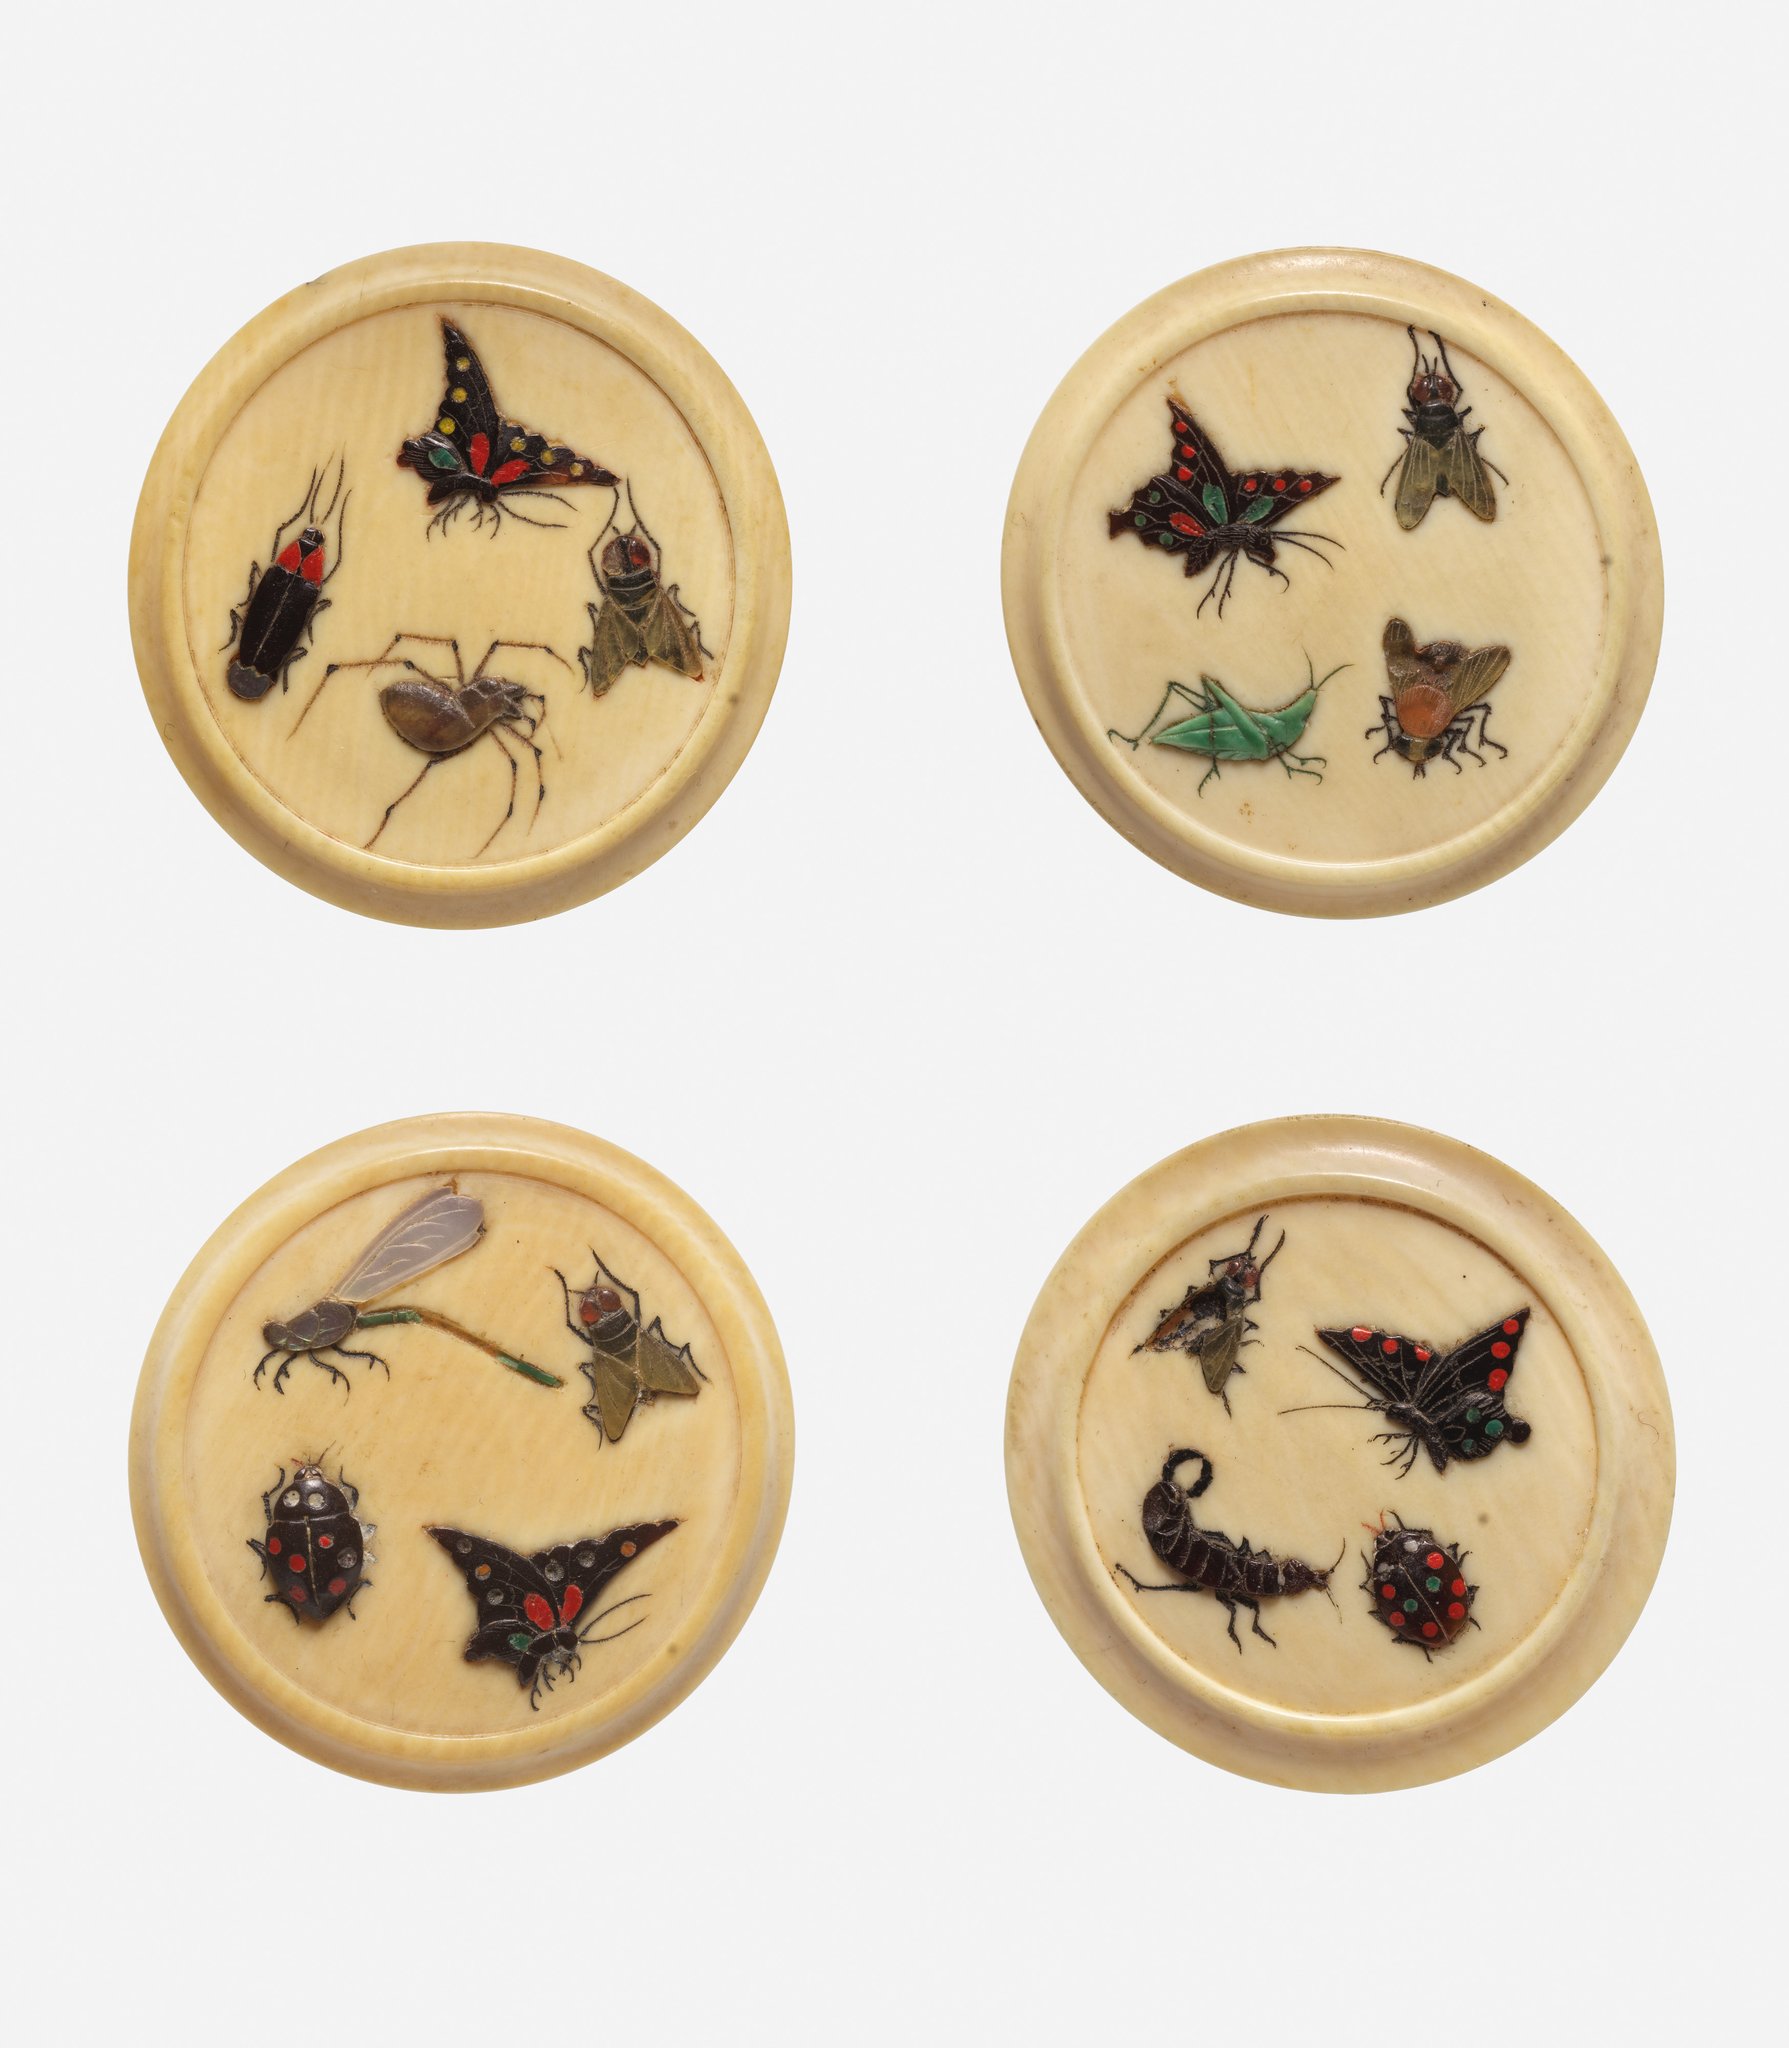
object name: button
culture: japanese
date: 1850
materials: ivory, mother of pearl, shell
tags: bees,butterflies,dragonflies,scorpions